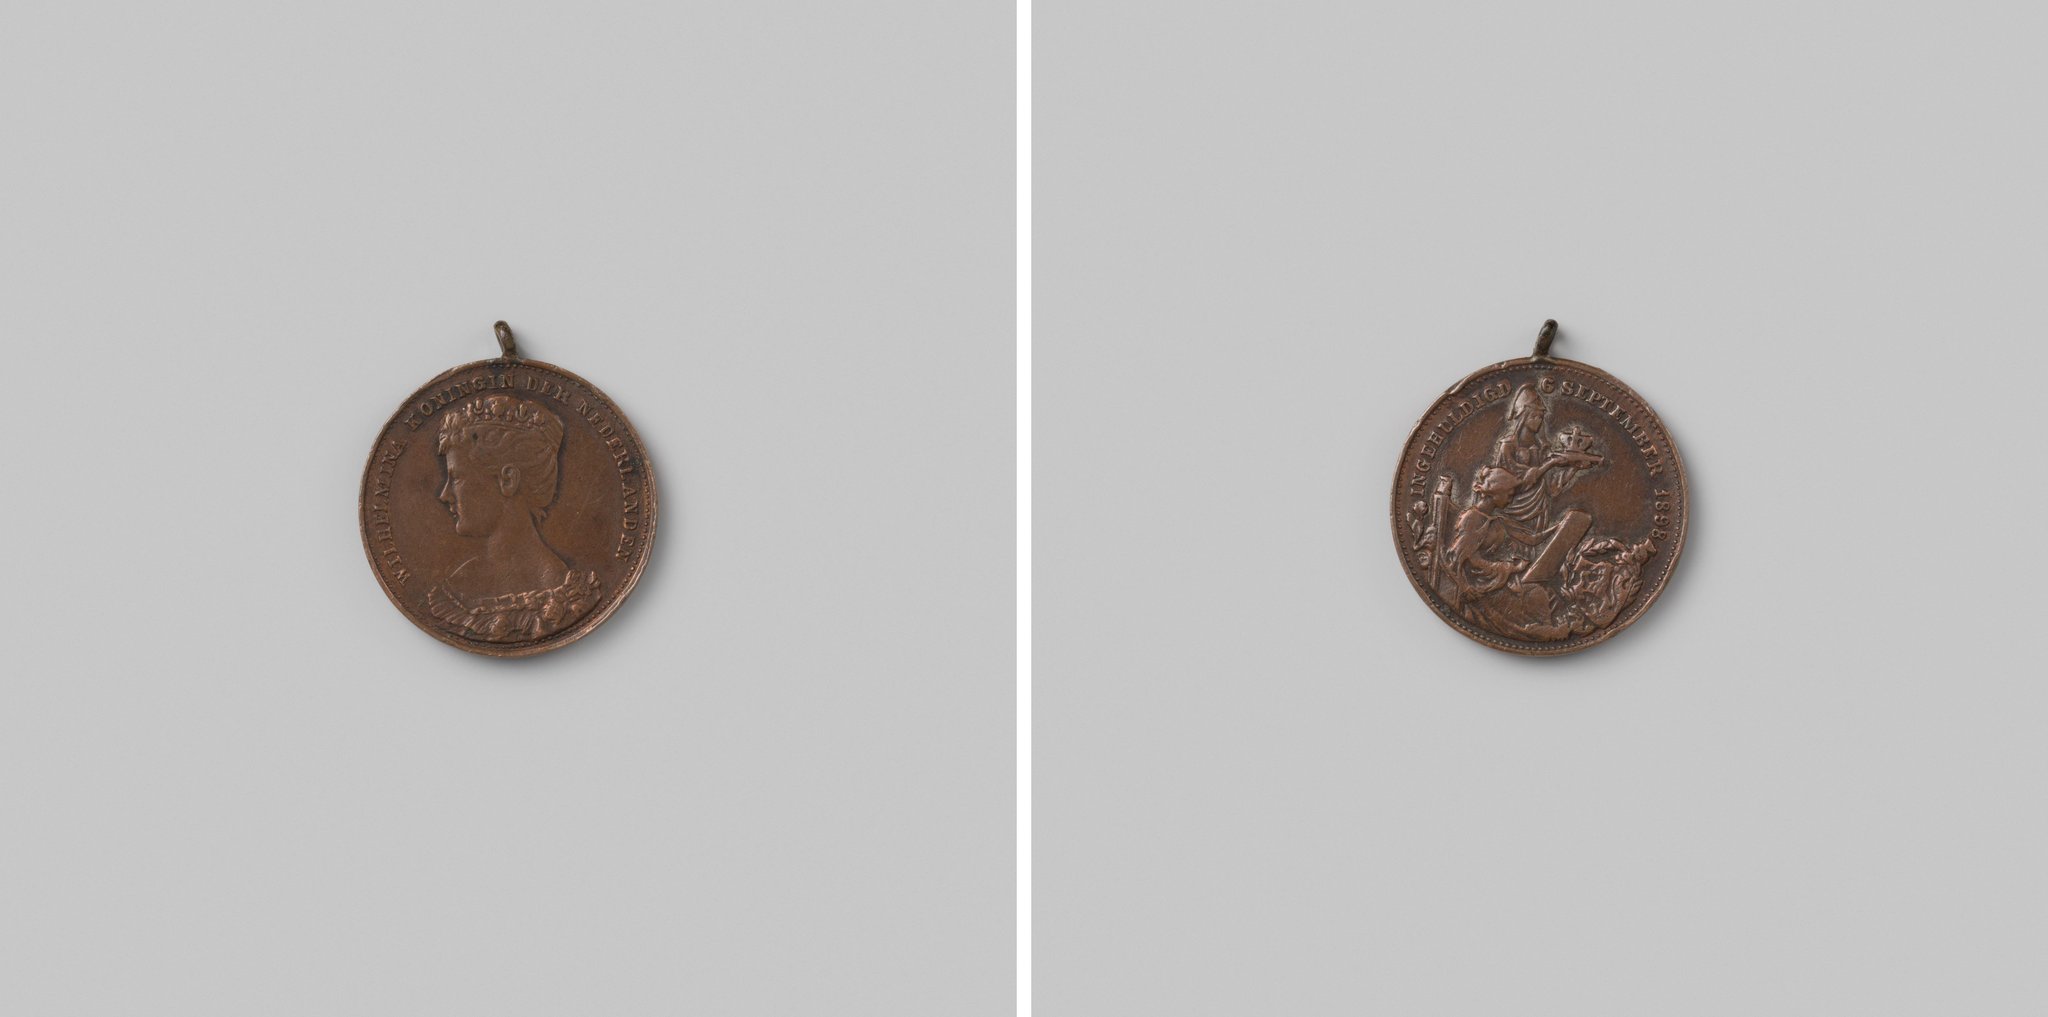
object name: history medal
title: Inhuldiging van Wilhelmina als koningin der Nederlanden, penning uitgedeeld onder schoolkinderen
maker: johannes albertus adolf gerritsen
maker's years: 1840-1904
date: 1898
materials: copper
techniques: striking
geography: amsterdam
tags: print maker, wilhelmina of the netherlands, netherlands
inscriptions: circumscription: ‘INGEHULDIGD 6 SEPTEMBER 1898’, circumscription: ‘WILHELMINA KONINGIN DER NEDERLANDEN’